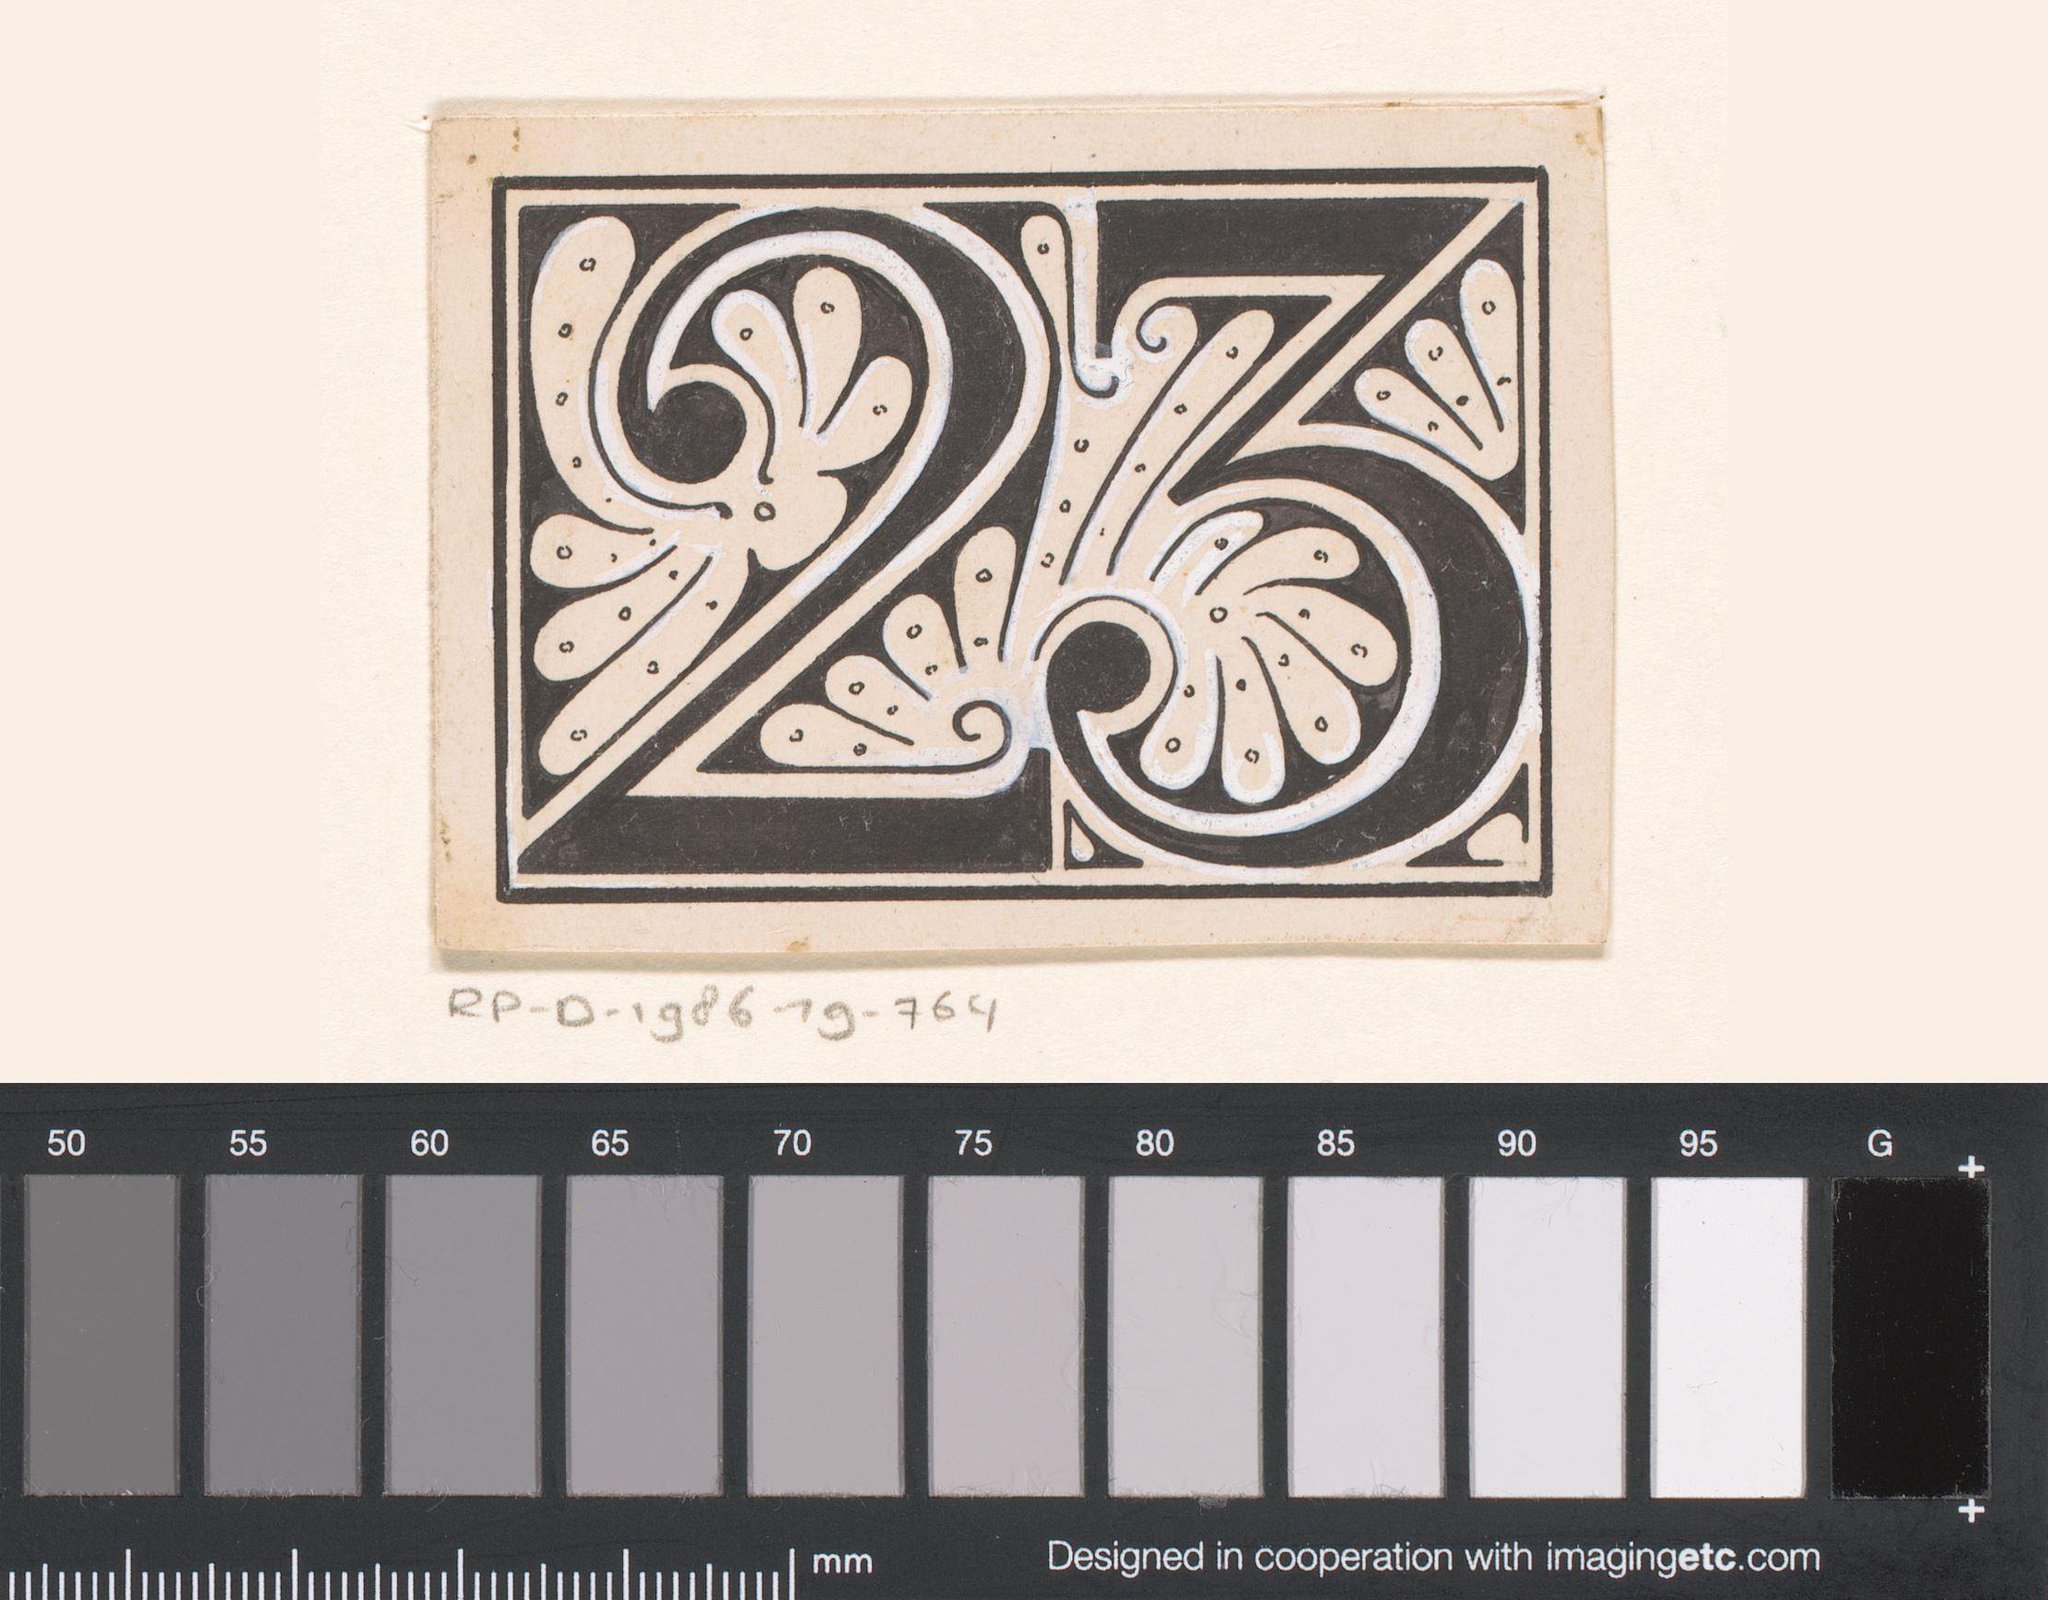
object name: drawing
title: Getal 23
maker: reinier willem petrus de vries (1874-1953)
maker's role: draughtsman, print maker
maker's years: 1874-1953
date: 1904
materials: paint, ink, paper, pencil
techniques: brush, pen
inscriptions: collector's mark: ‘R:MVS.’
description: Het getal is gebruikt voor: Veth, Jan. Jozef Israëls en zijn kunst. Arnhem en Nijmegen: Gebroeders E&M Cohen, 1904.